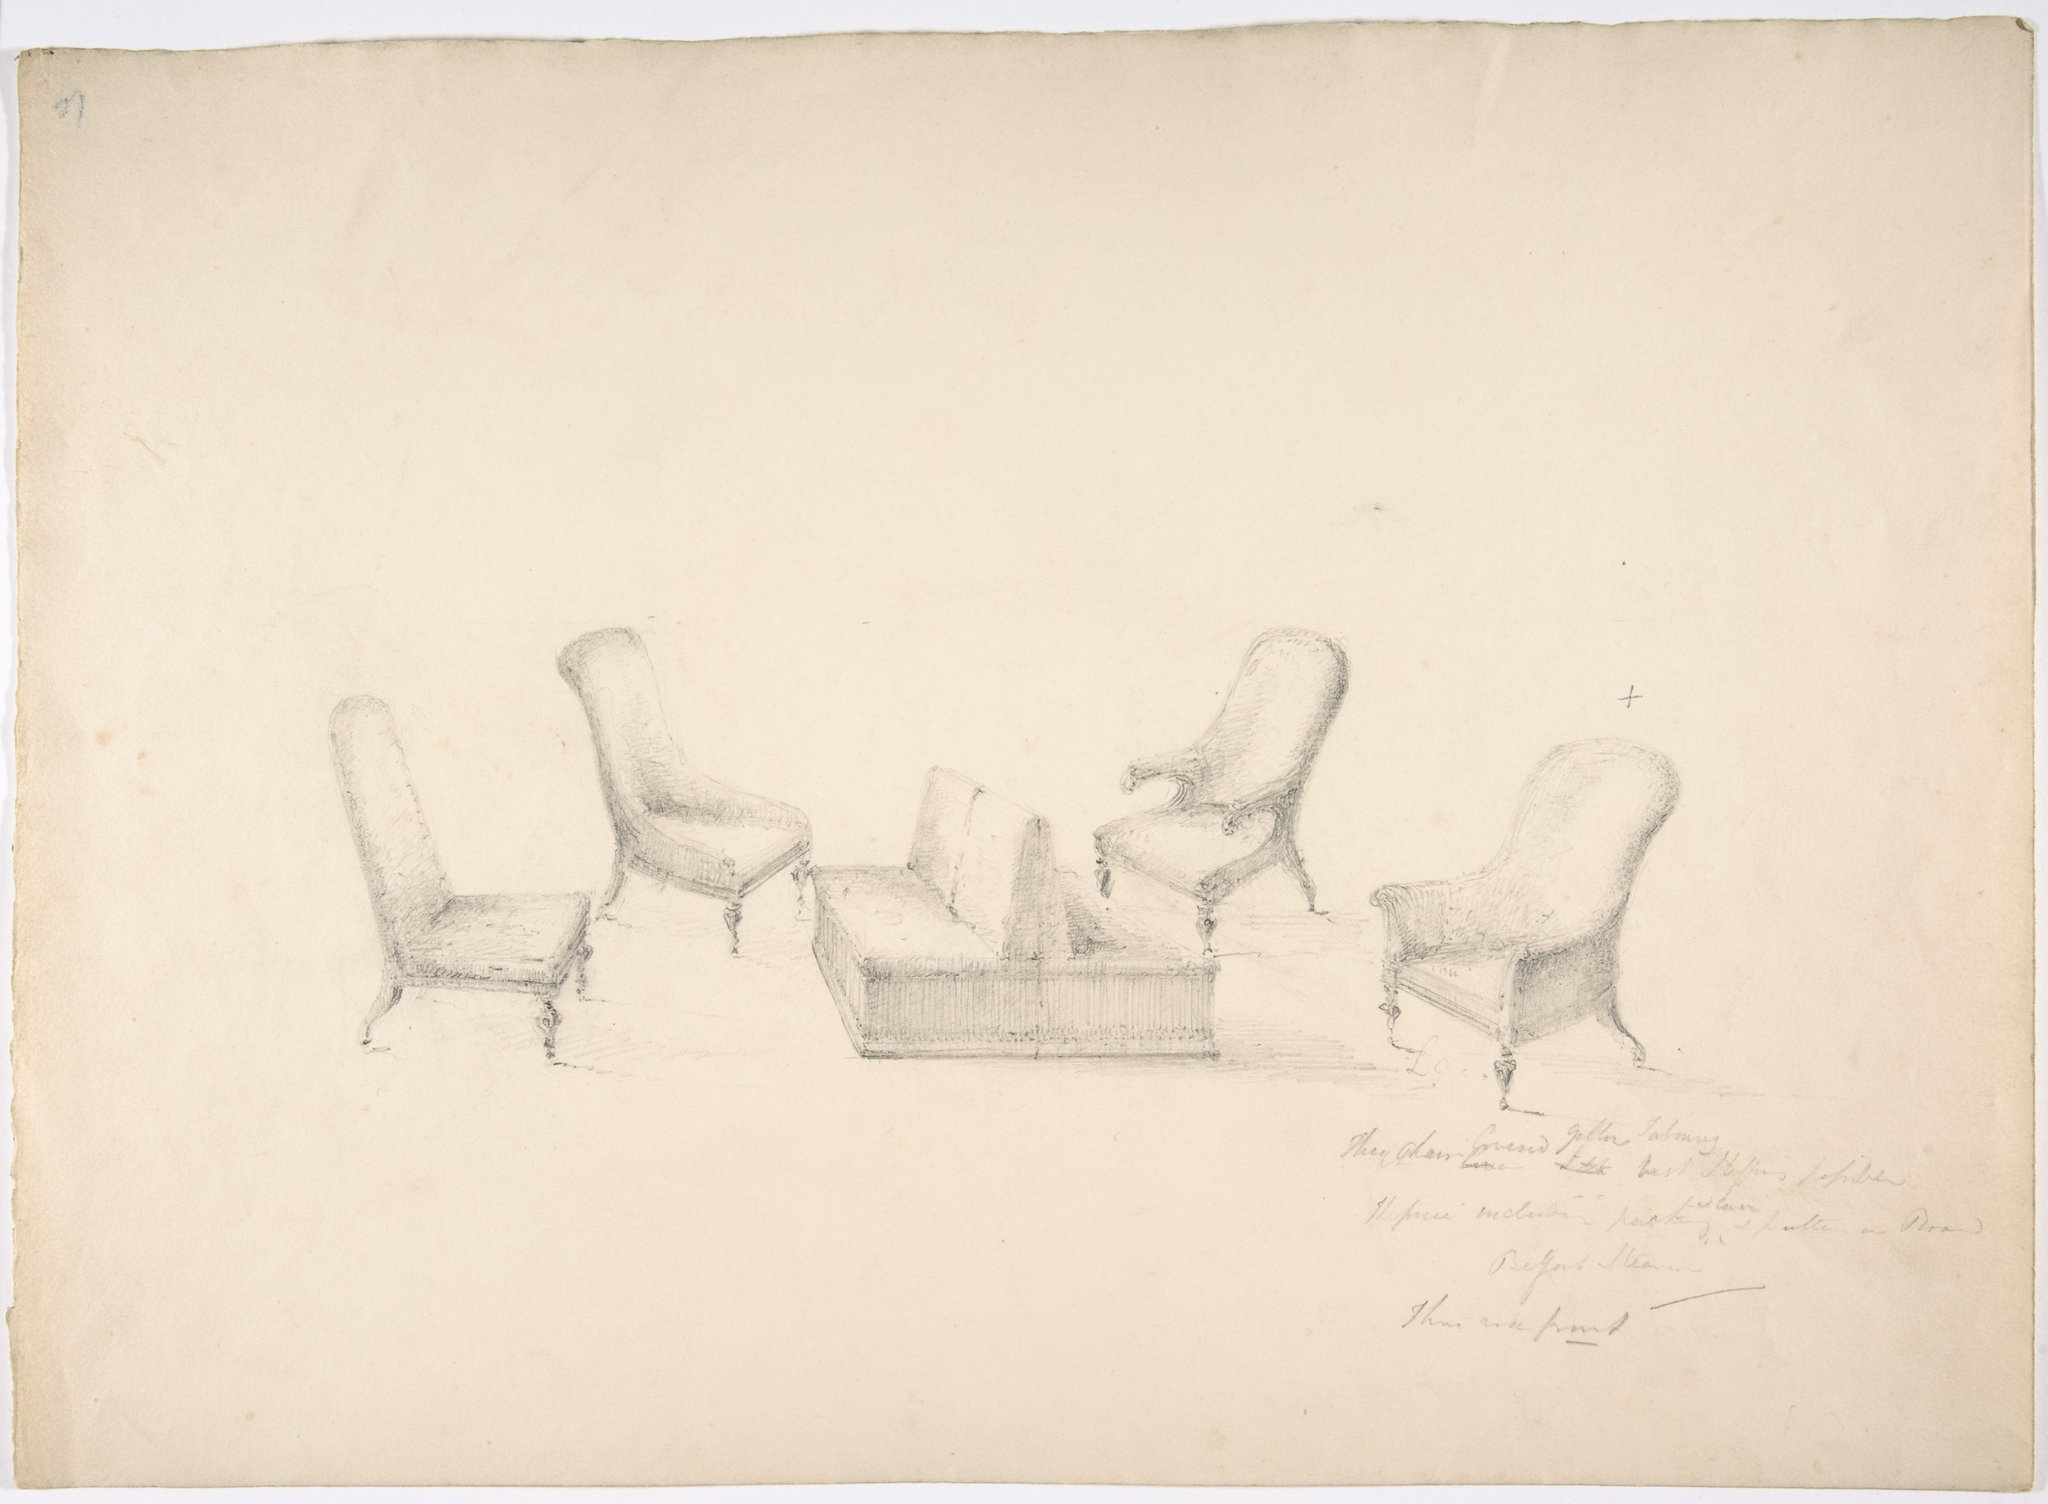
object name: drawing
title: Design for a Suite of Furniture, A Double-sided Sofa, Two Chairs and Two Armchairs (Verso: sketch for shelves and a mirror)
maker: anonymous, british, 19th century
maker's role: artist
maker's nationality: british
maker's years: 1800-1900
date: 1801-1833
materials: graphite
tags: chairs,couches